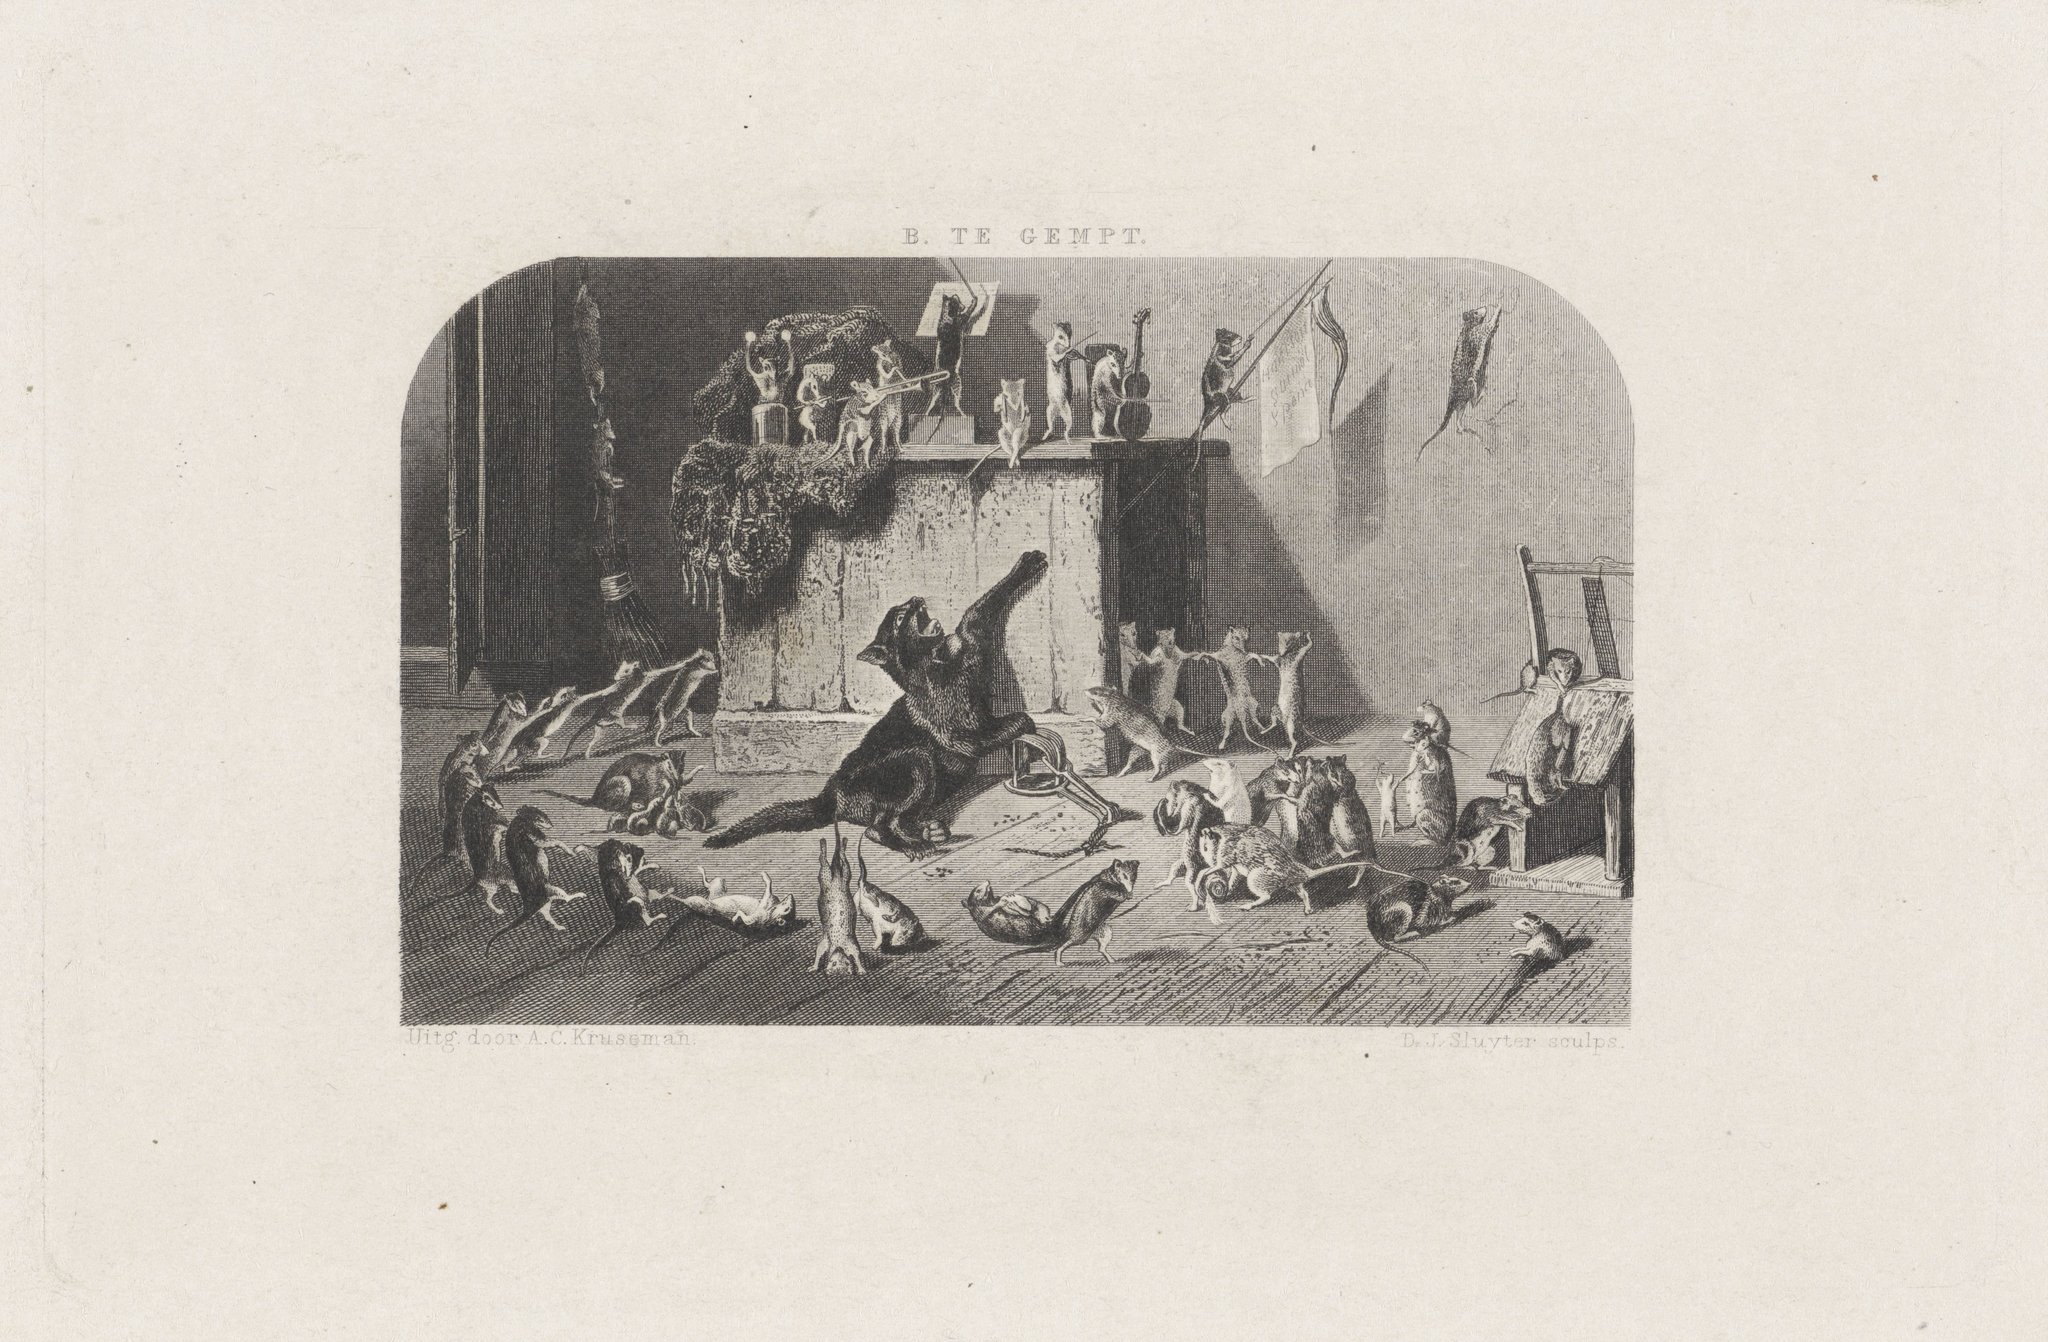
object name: print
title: Muizenfeest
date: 1861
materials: paper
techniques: etching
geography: haarlem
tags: cat and mouse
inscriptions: collector's mark: Lugt 2228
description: Een kat zit gevangen in een klem. Rondom vieren de muizen feest: ze dansen. musiceren en zwaaien met een vlag.